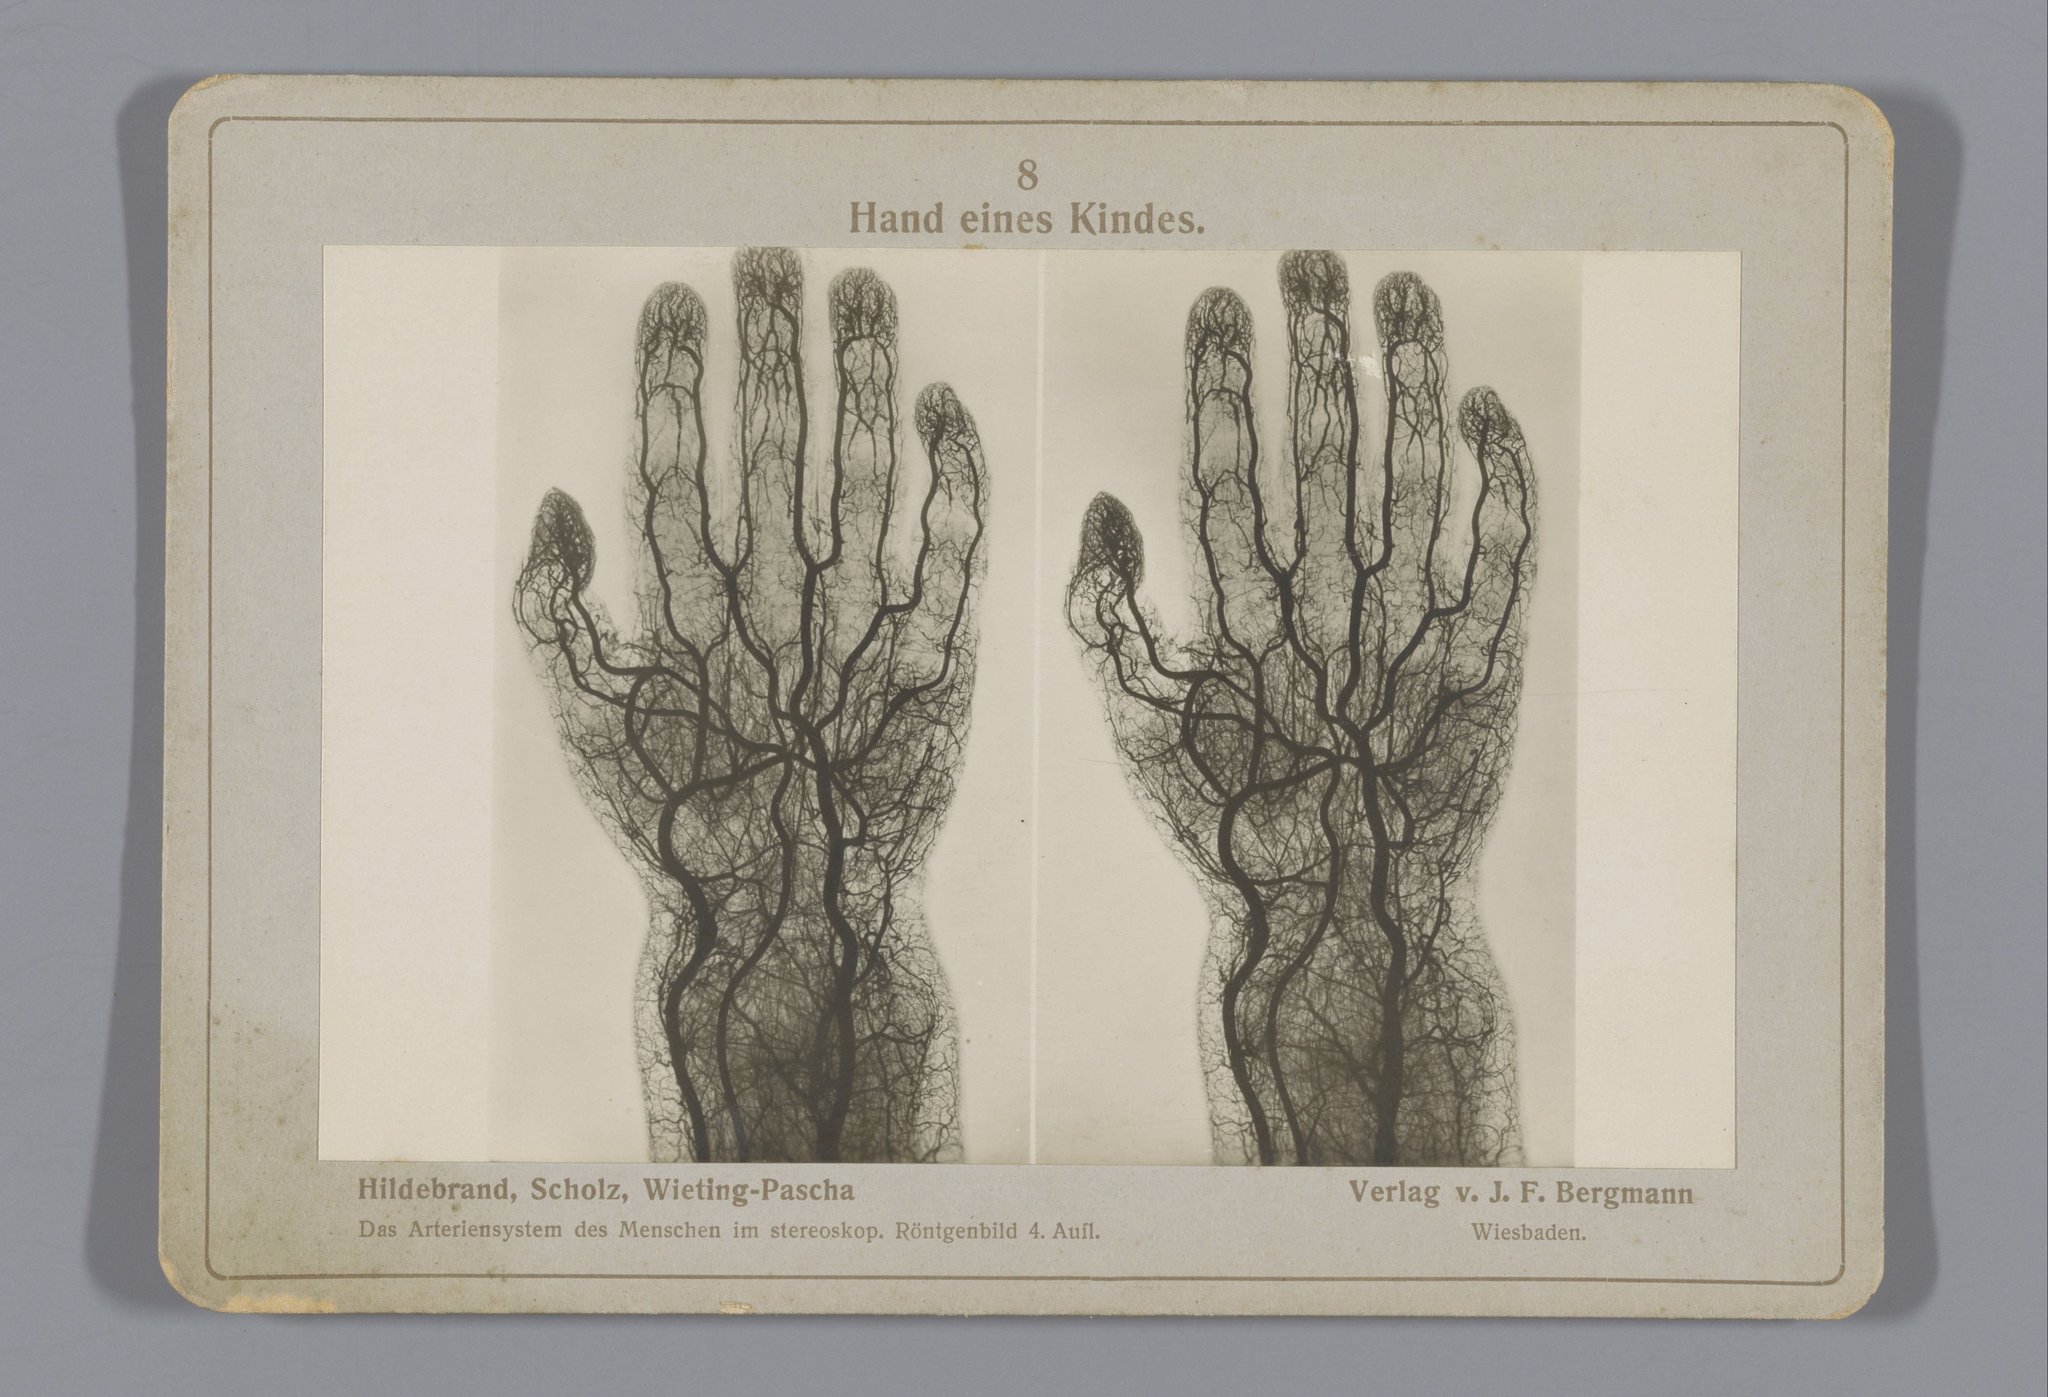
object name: x ray photograph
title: Hand eines Kindes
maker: joseph friedrich bergmann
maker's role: publisher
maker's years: 1849-1917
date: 1917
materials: paper, cardboard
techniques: gelatin silver print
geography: wiesbaden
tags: arteries, hand, physiology and anatomy ~ circulatory system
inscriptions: number: ‘8’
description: Foto afkomstig uit: Hildebrand, O., W. Scholz en J. Wieting. Das Arteriensystem des Menschen im stereoskopischen Röntgenbild, Sammlung von stereoskopischen Röntgenbildern aus dem Neuen Allgemeinen Krankenhaus Hamburg-Eppendorf. 4de druk. Wiesbaden: J.F. Bergmann, 1917.